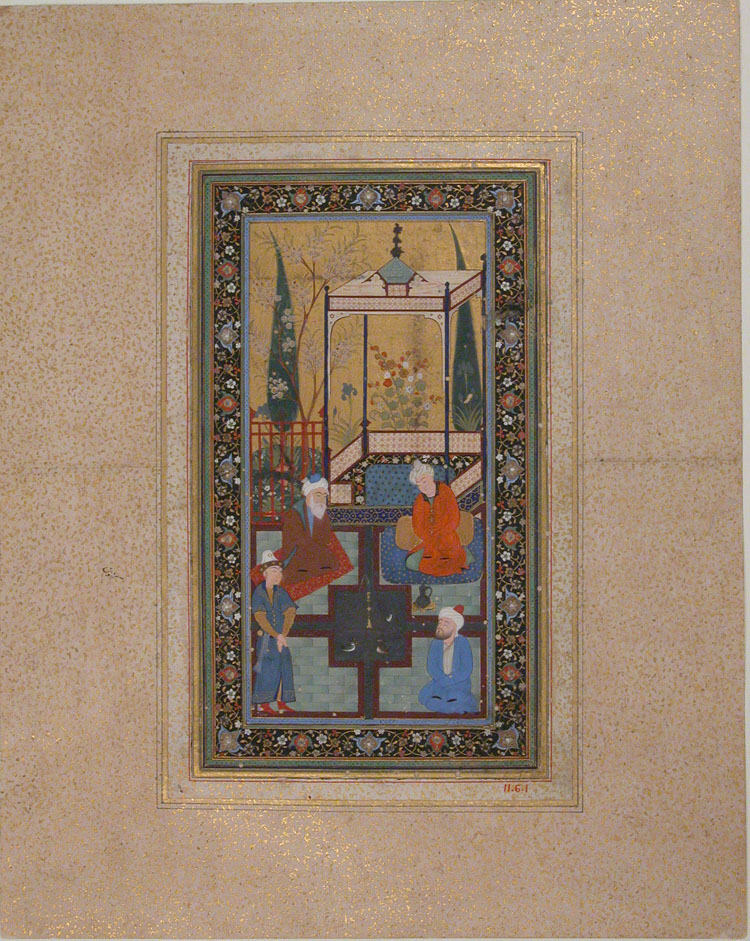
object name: folio from an illustrated manuscript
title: Garden Scene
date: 1534-1566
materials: gold, ink, paper, watercolor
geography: uzbekistan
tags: gardens,men